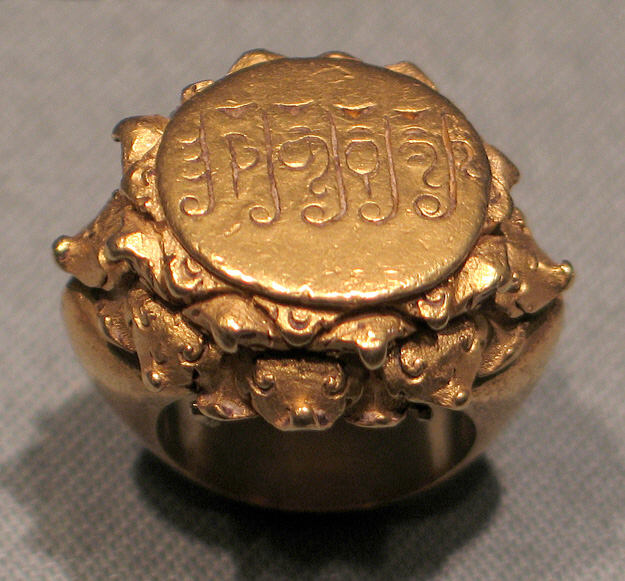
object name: ring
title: Stirrup-Shaped Ring with Oval Bezel with Nagari Script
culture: indonesian, javanese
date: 701-933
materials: gold